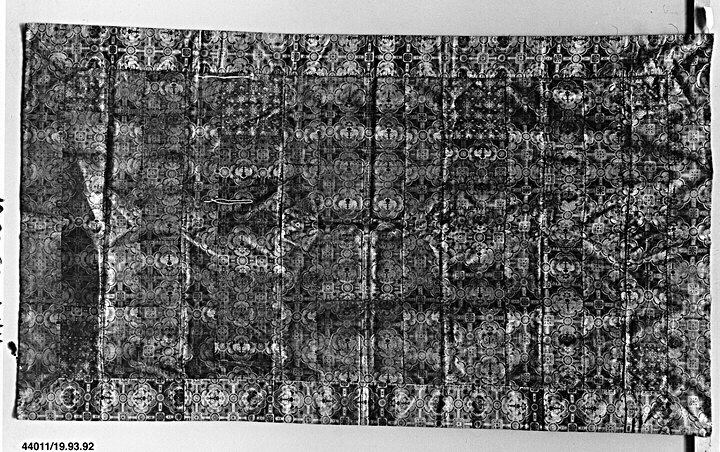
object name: robe, priest's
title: Priest's Robe (Shichijō)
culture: japanese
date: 1701-1800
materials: metal thread, silk